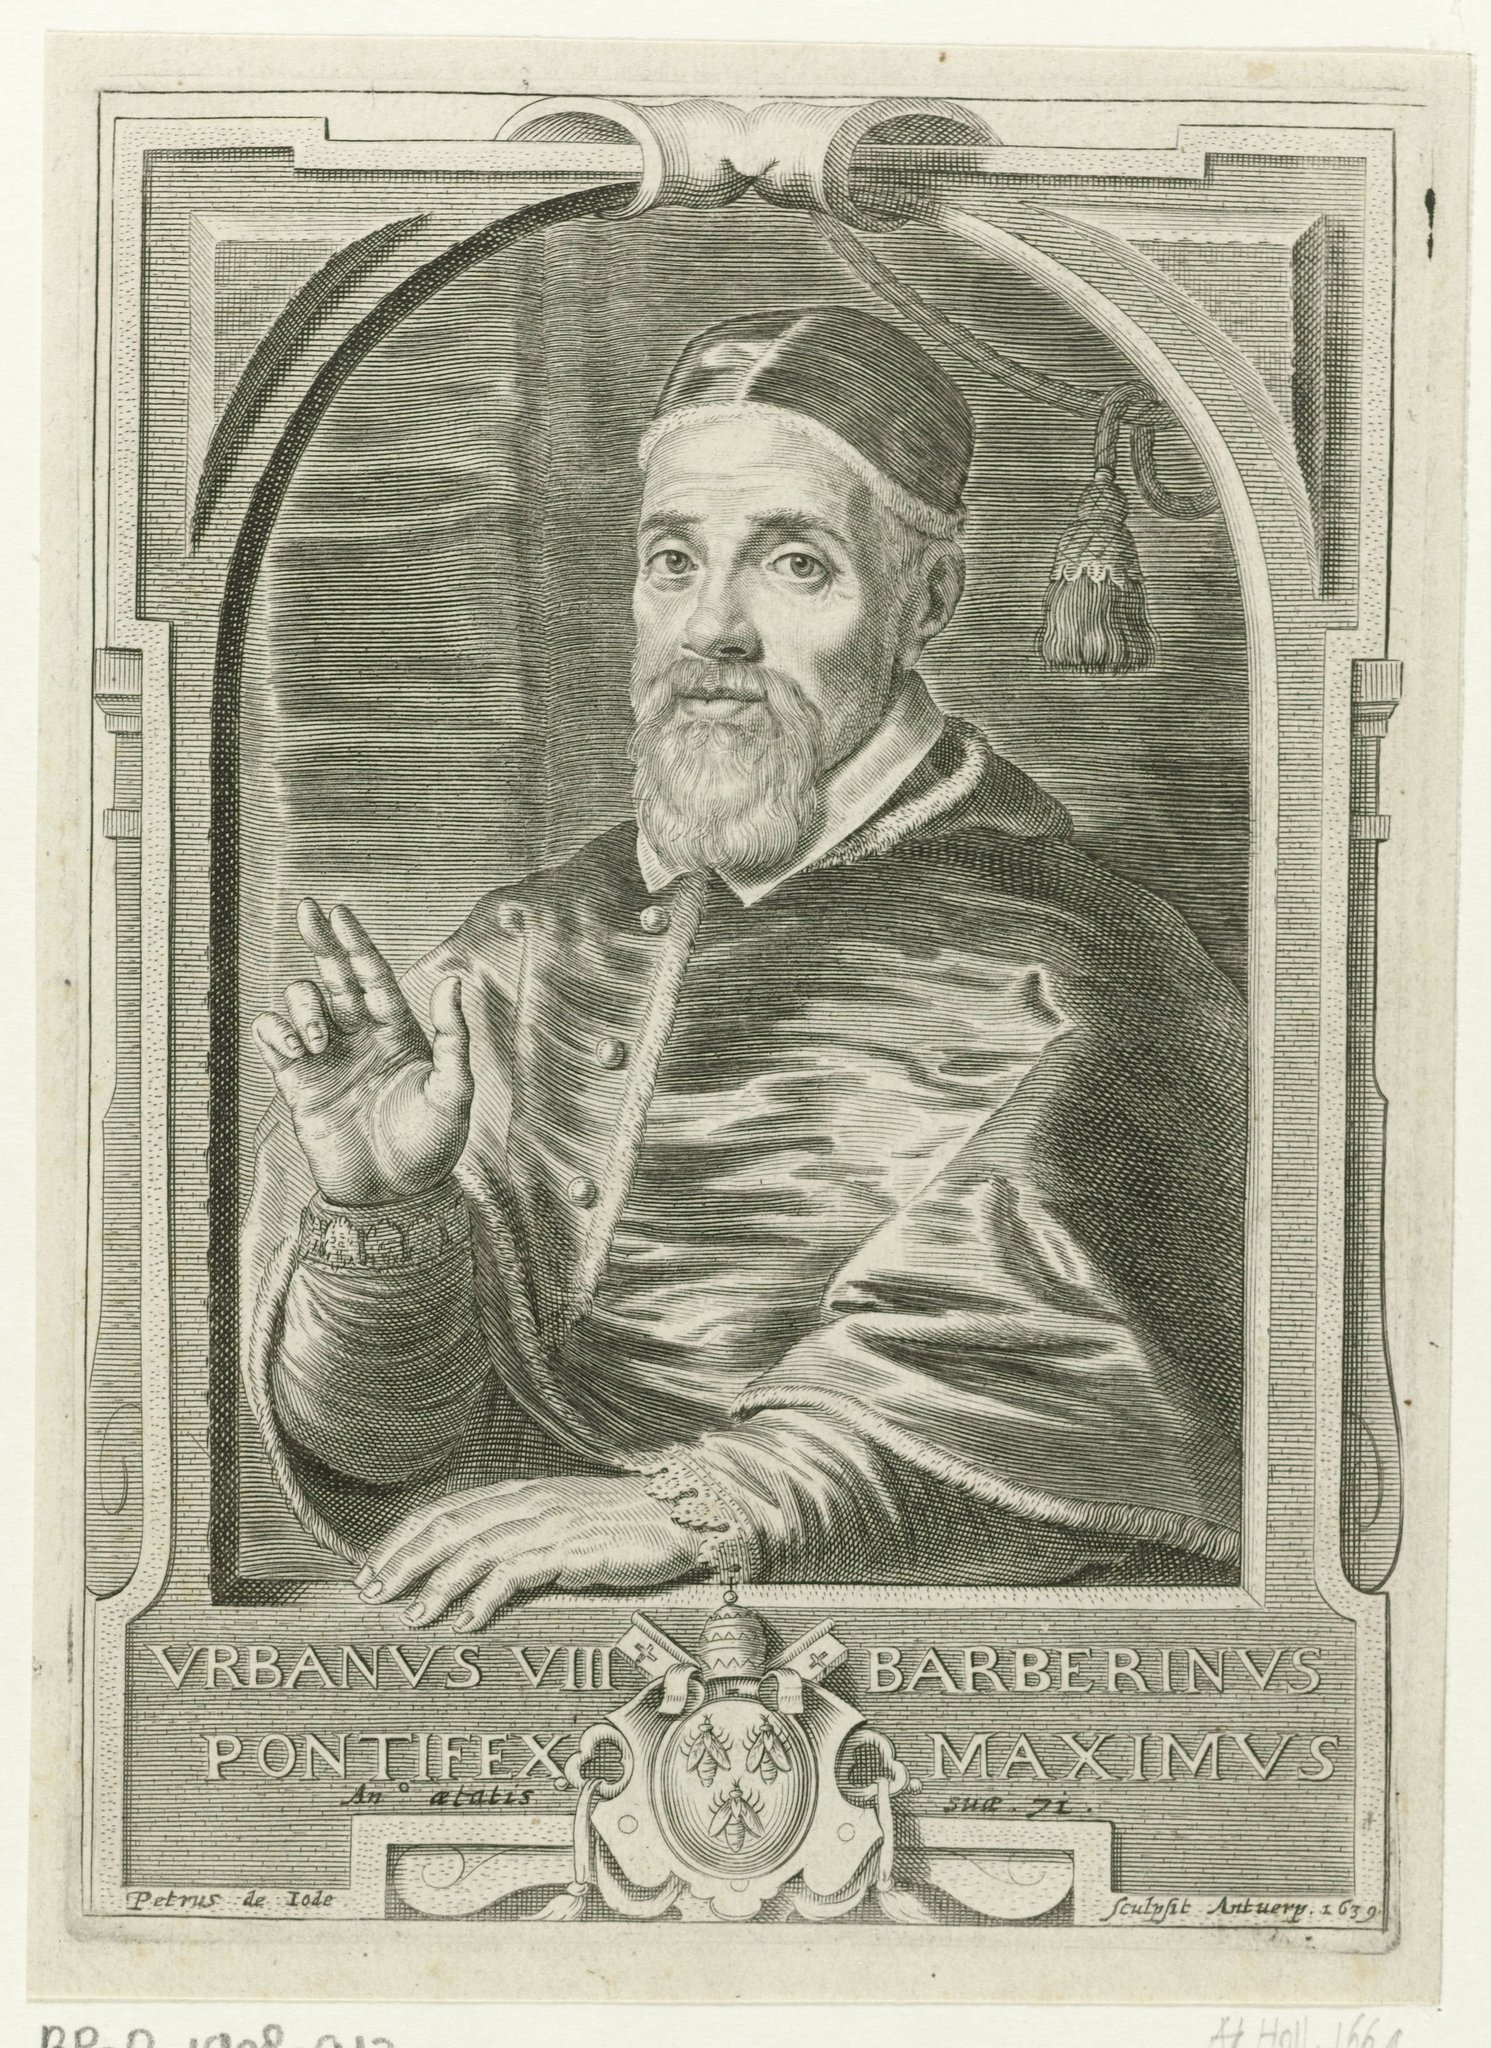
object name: print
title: Theater van bisschoppen, keizers, koningen, hertogen, prinsen, enz.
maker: pieter de jode (ii)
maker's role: draughtsman, print maker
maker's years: 1606-1674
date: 1639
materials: paper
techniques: engraving, etching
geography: antwerp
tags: rome, clergyman, urbanus viii, head-gear (camauro) (+ men's clothes)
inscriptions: collector's mark: Lugt 2228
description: Busteportret van paus Urbanus VIII op 71-jarige leeftijd, met camauro. Met zijn rechterhand maakt hij een zegenend gebaar en met zijn linkerhand rust hij op de omlijsting. Het portret is gevat in een boogvormige omlijsting met het wapenschild van de geportretteerde en een tweeregelig onderschrift in het Latijn.